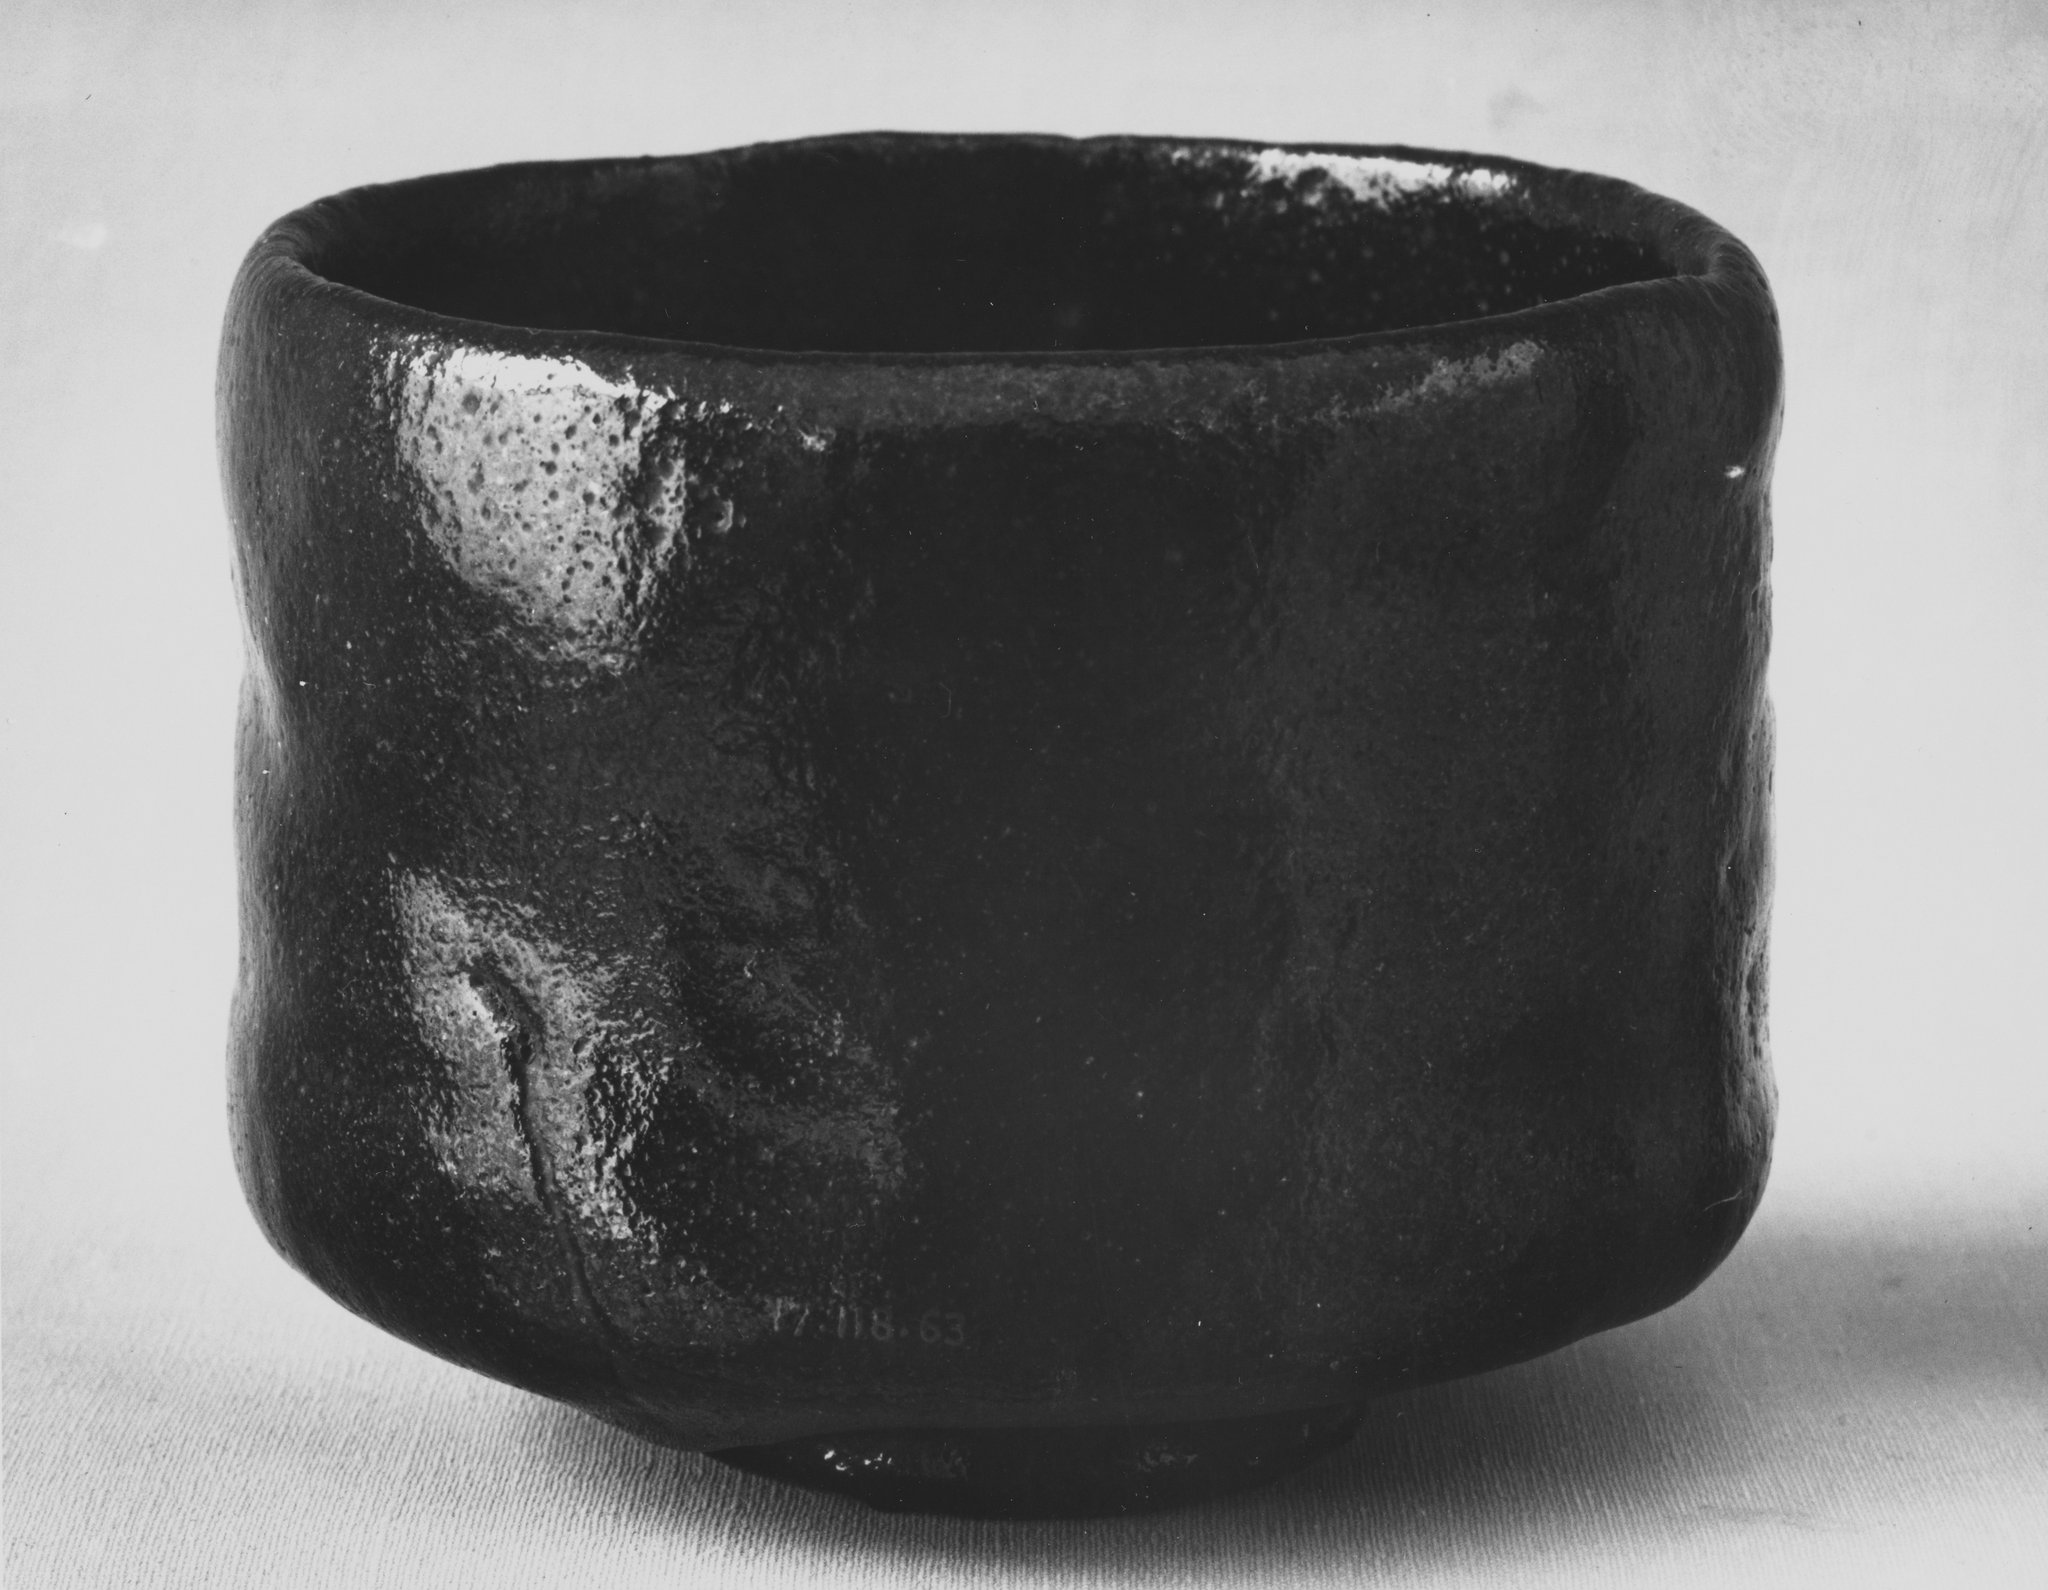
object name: teabowl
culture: japanese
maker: ichigen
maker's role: artist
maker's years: 1622-1722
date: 1720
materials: clay, glaze